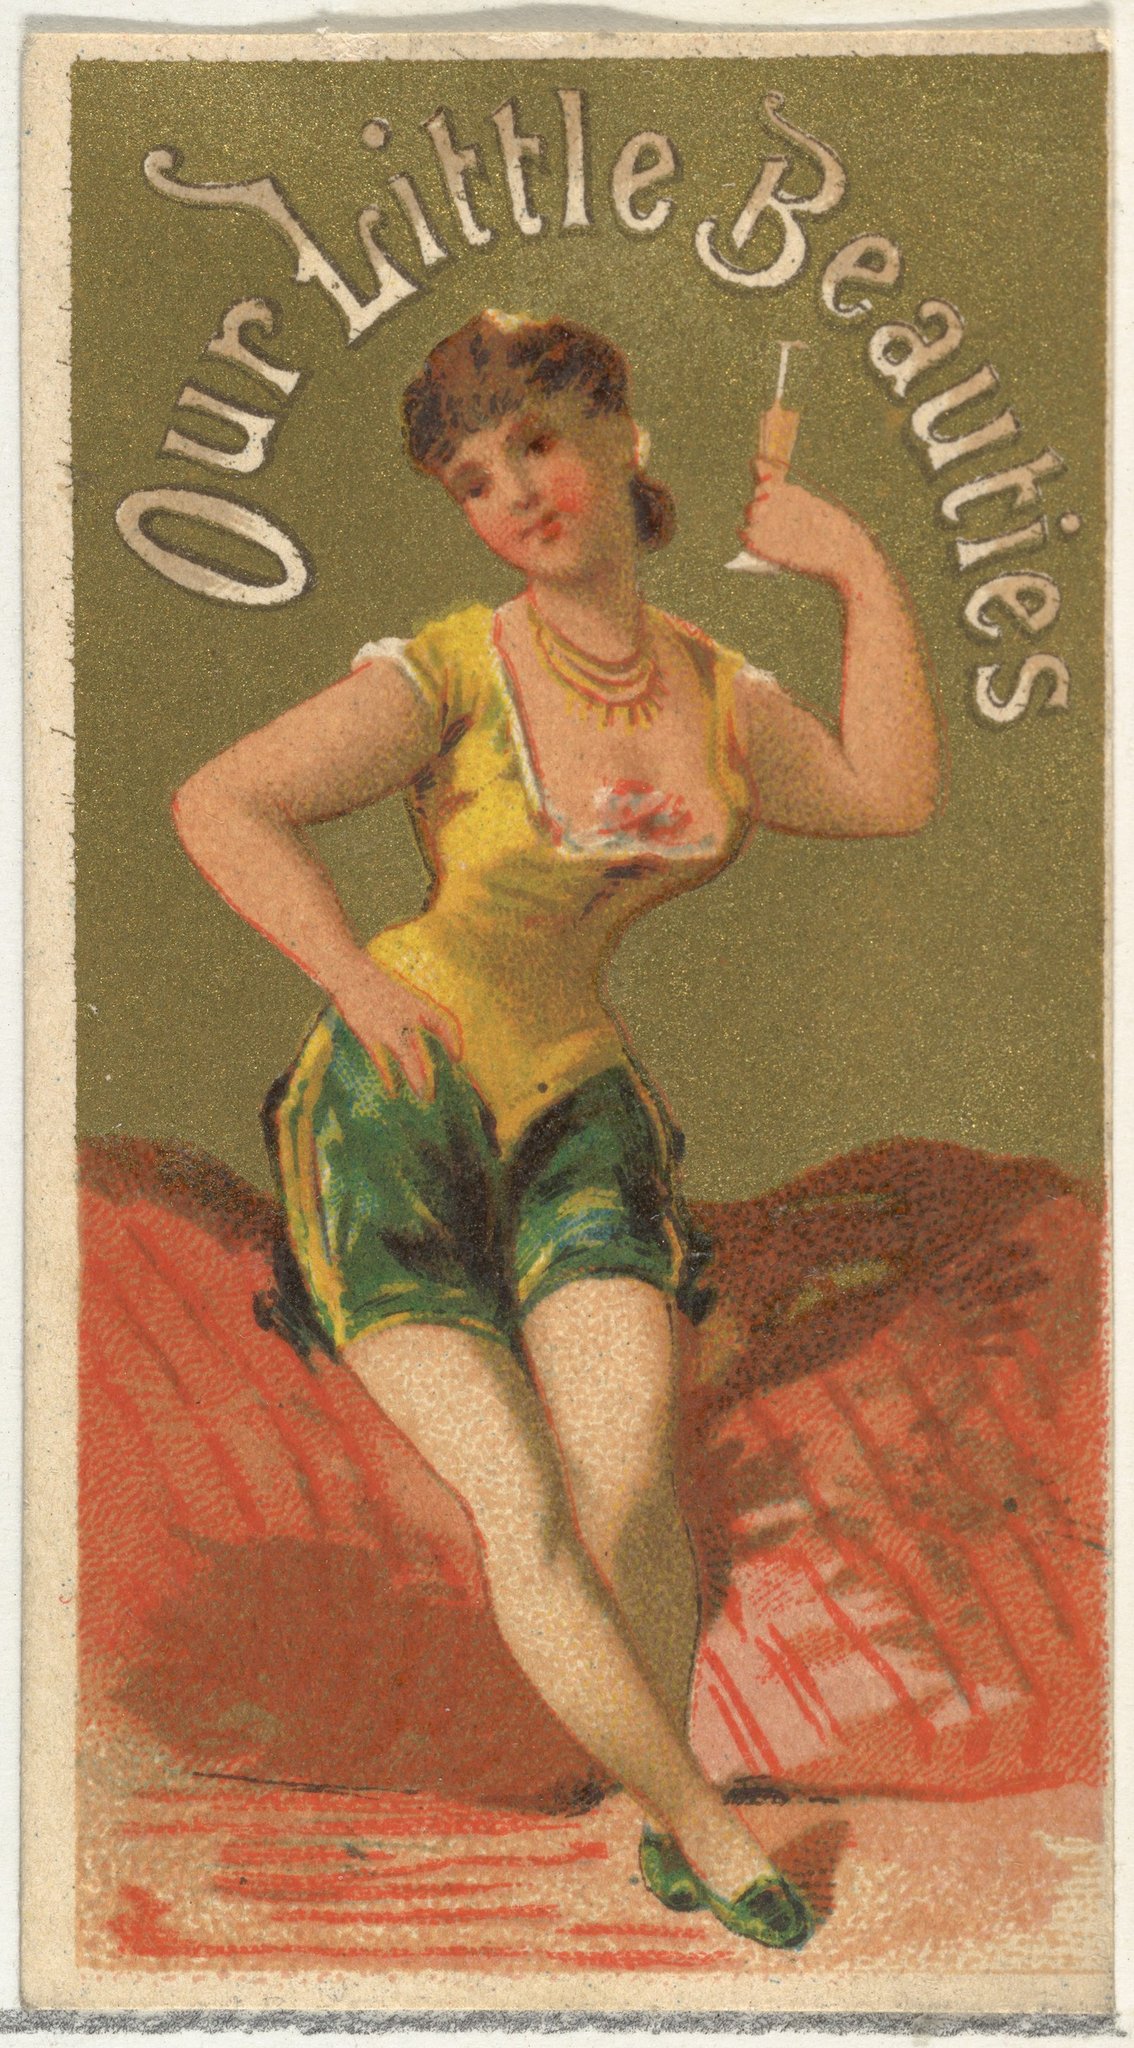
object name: print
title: From the Girls and Children series (N58) promoting Our Little Beauties Cigarettes for Allen & Ginter brand tobacco products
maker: allen & ginter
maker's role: publisher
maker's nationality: american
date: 1887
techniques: color lithograph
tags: girls